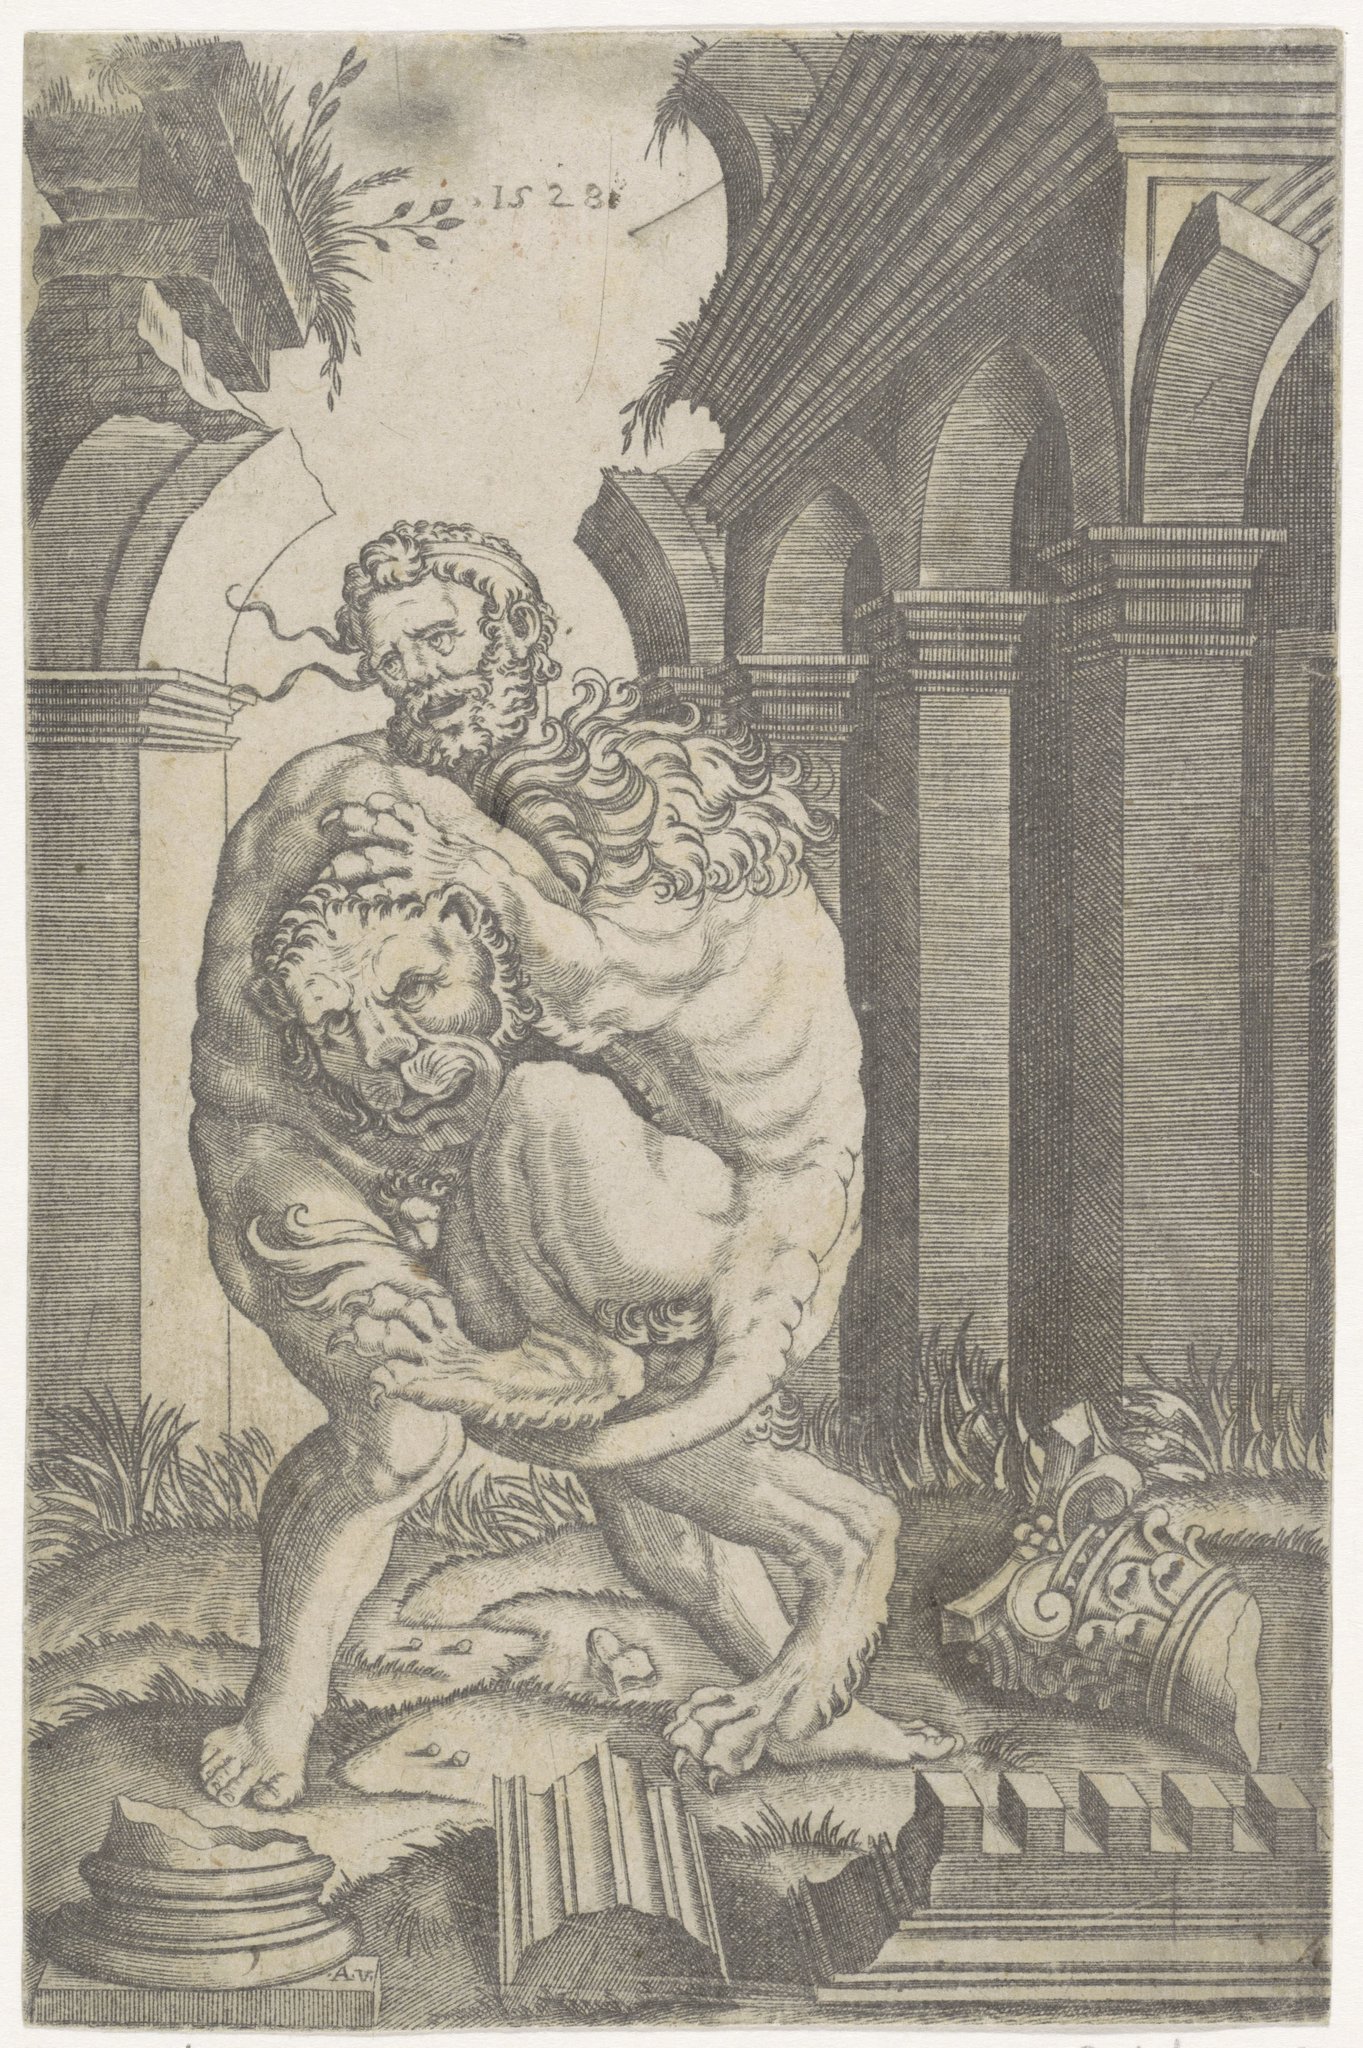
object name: print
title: Hercules en de Nemeïsche leeuw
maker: agostino veneziano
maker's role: draughtsman, painter, print maker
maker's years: 1490-1536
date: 1528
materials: paper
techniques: engraving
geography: italy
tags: (1) hercules chokes the nemean lion with his arms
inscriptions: collector's mark: Lugt 10, collector's mark: Lugt 11